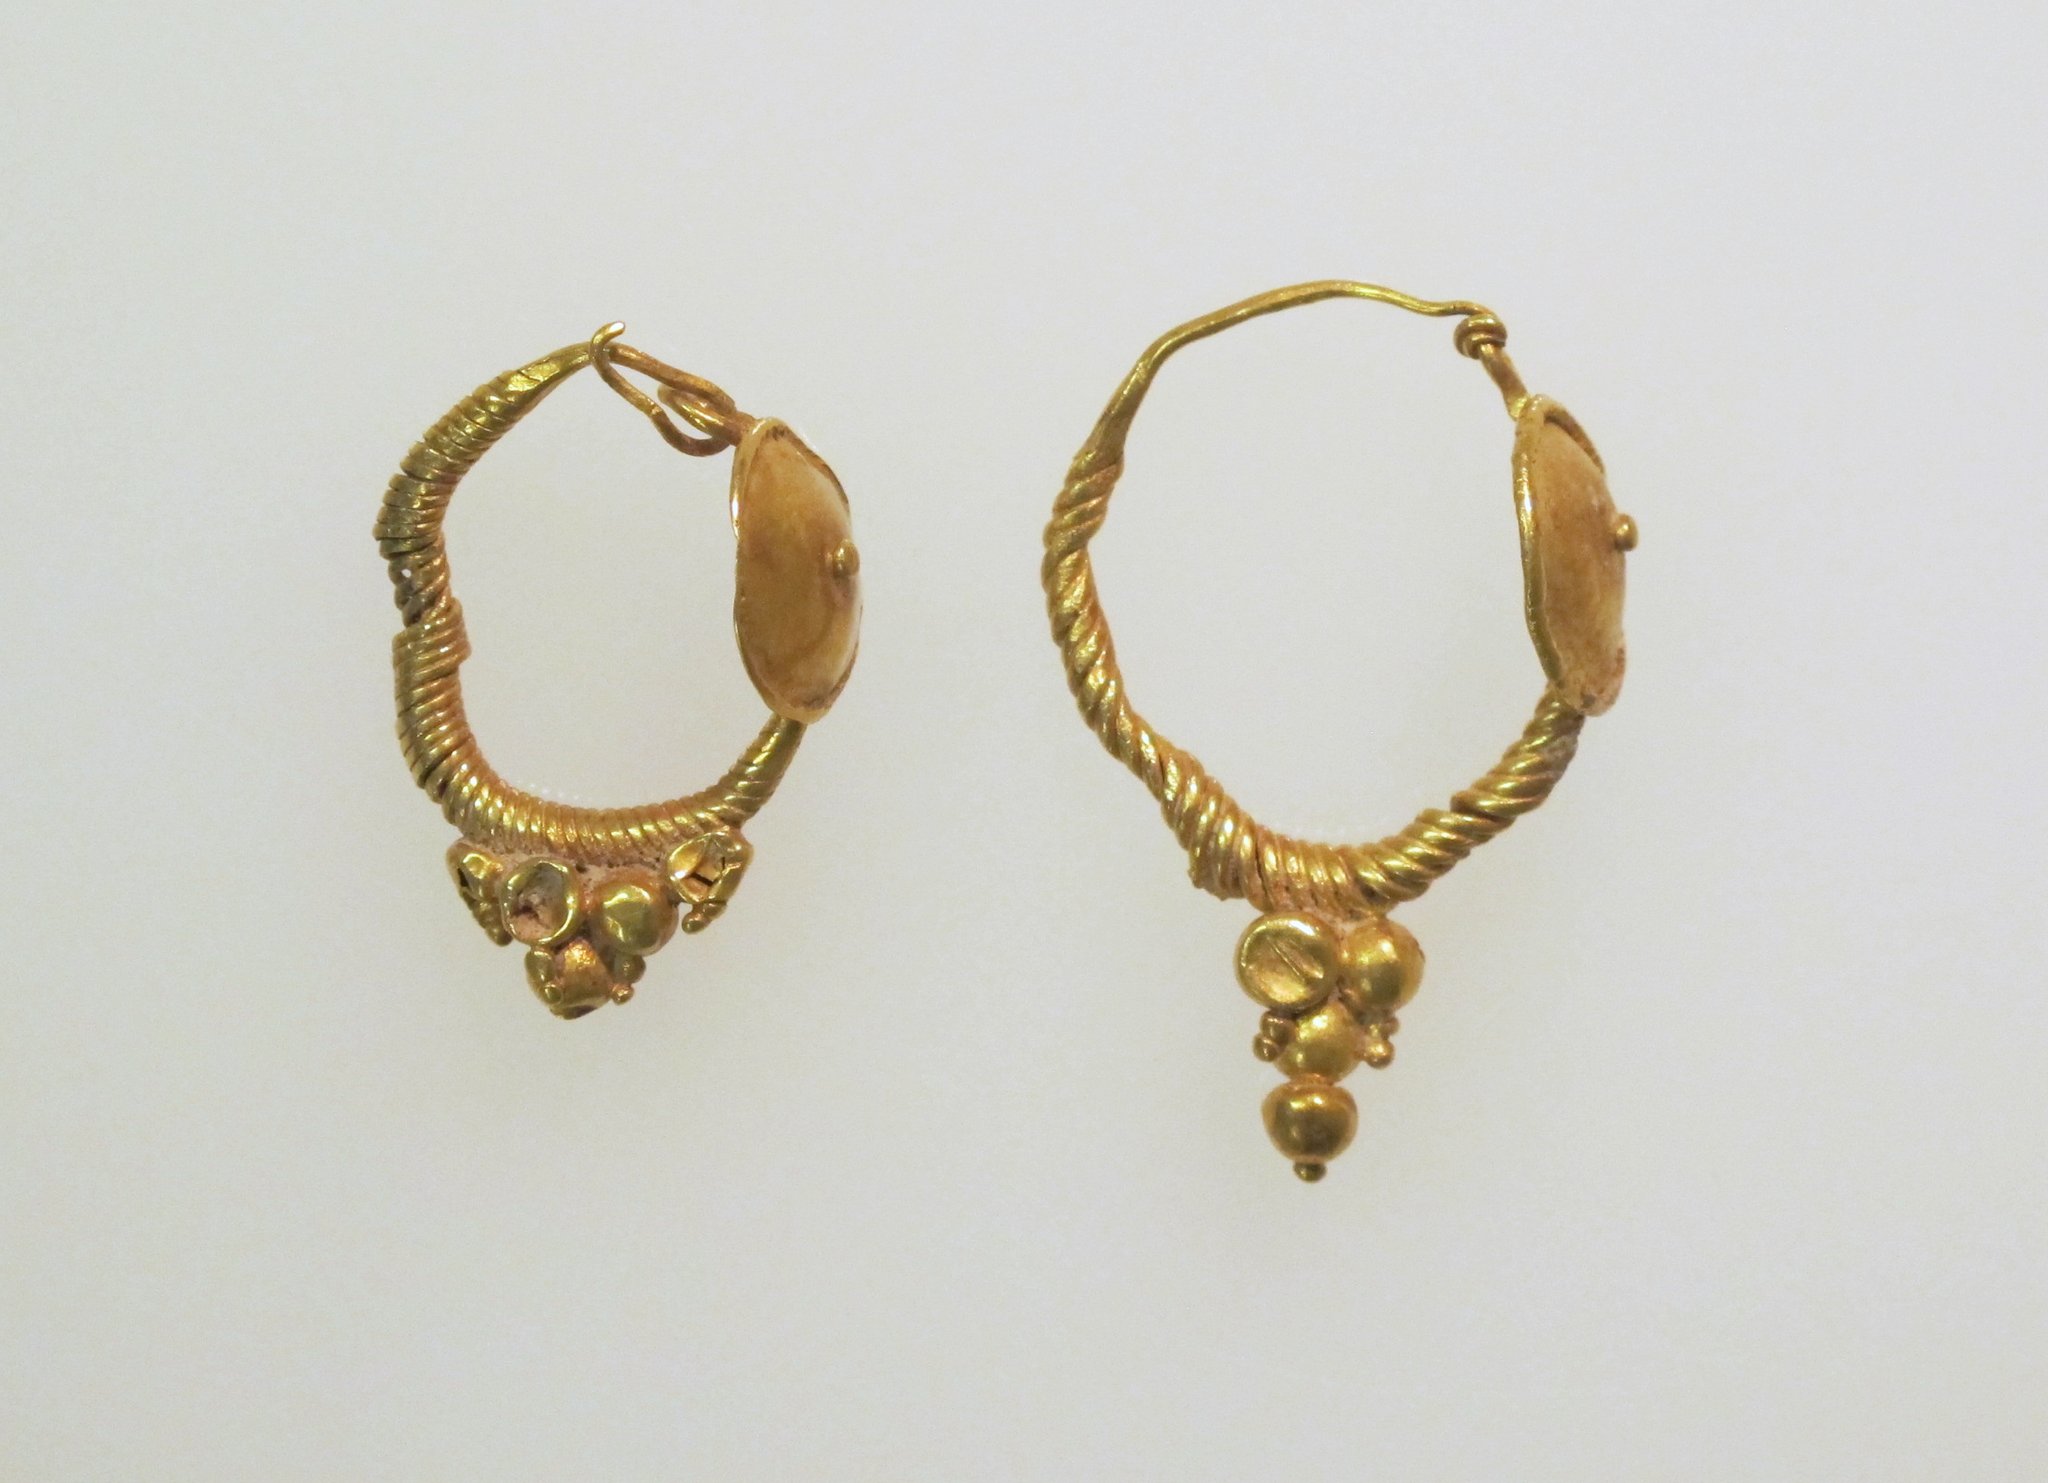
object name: earring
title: Earrings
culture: greek or roman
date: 146-30 BCE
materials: gold